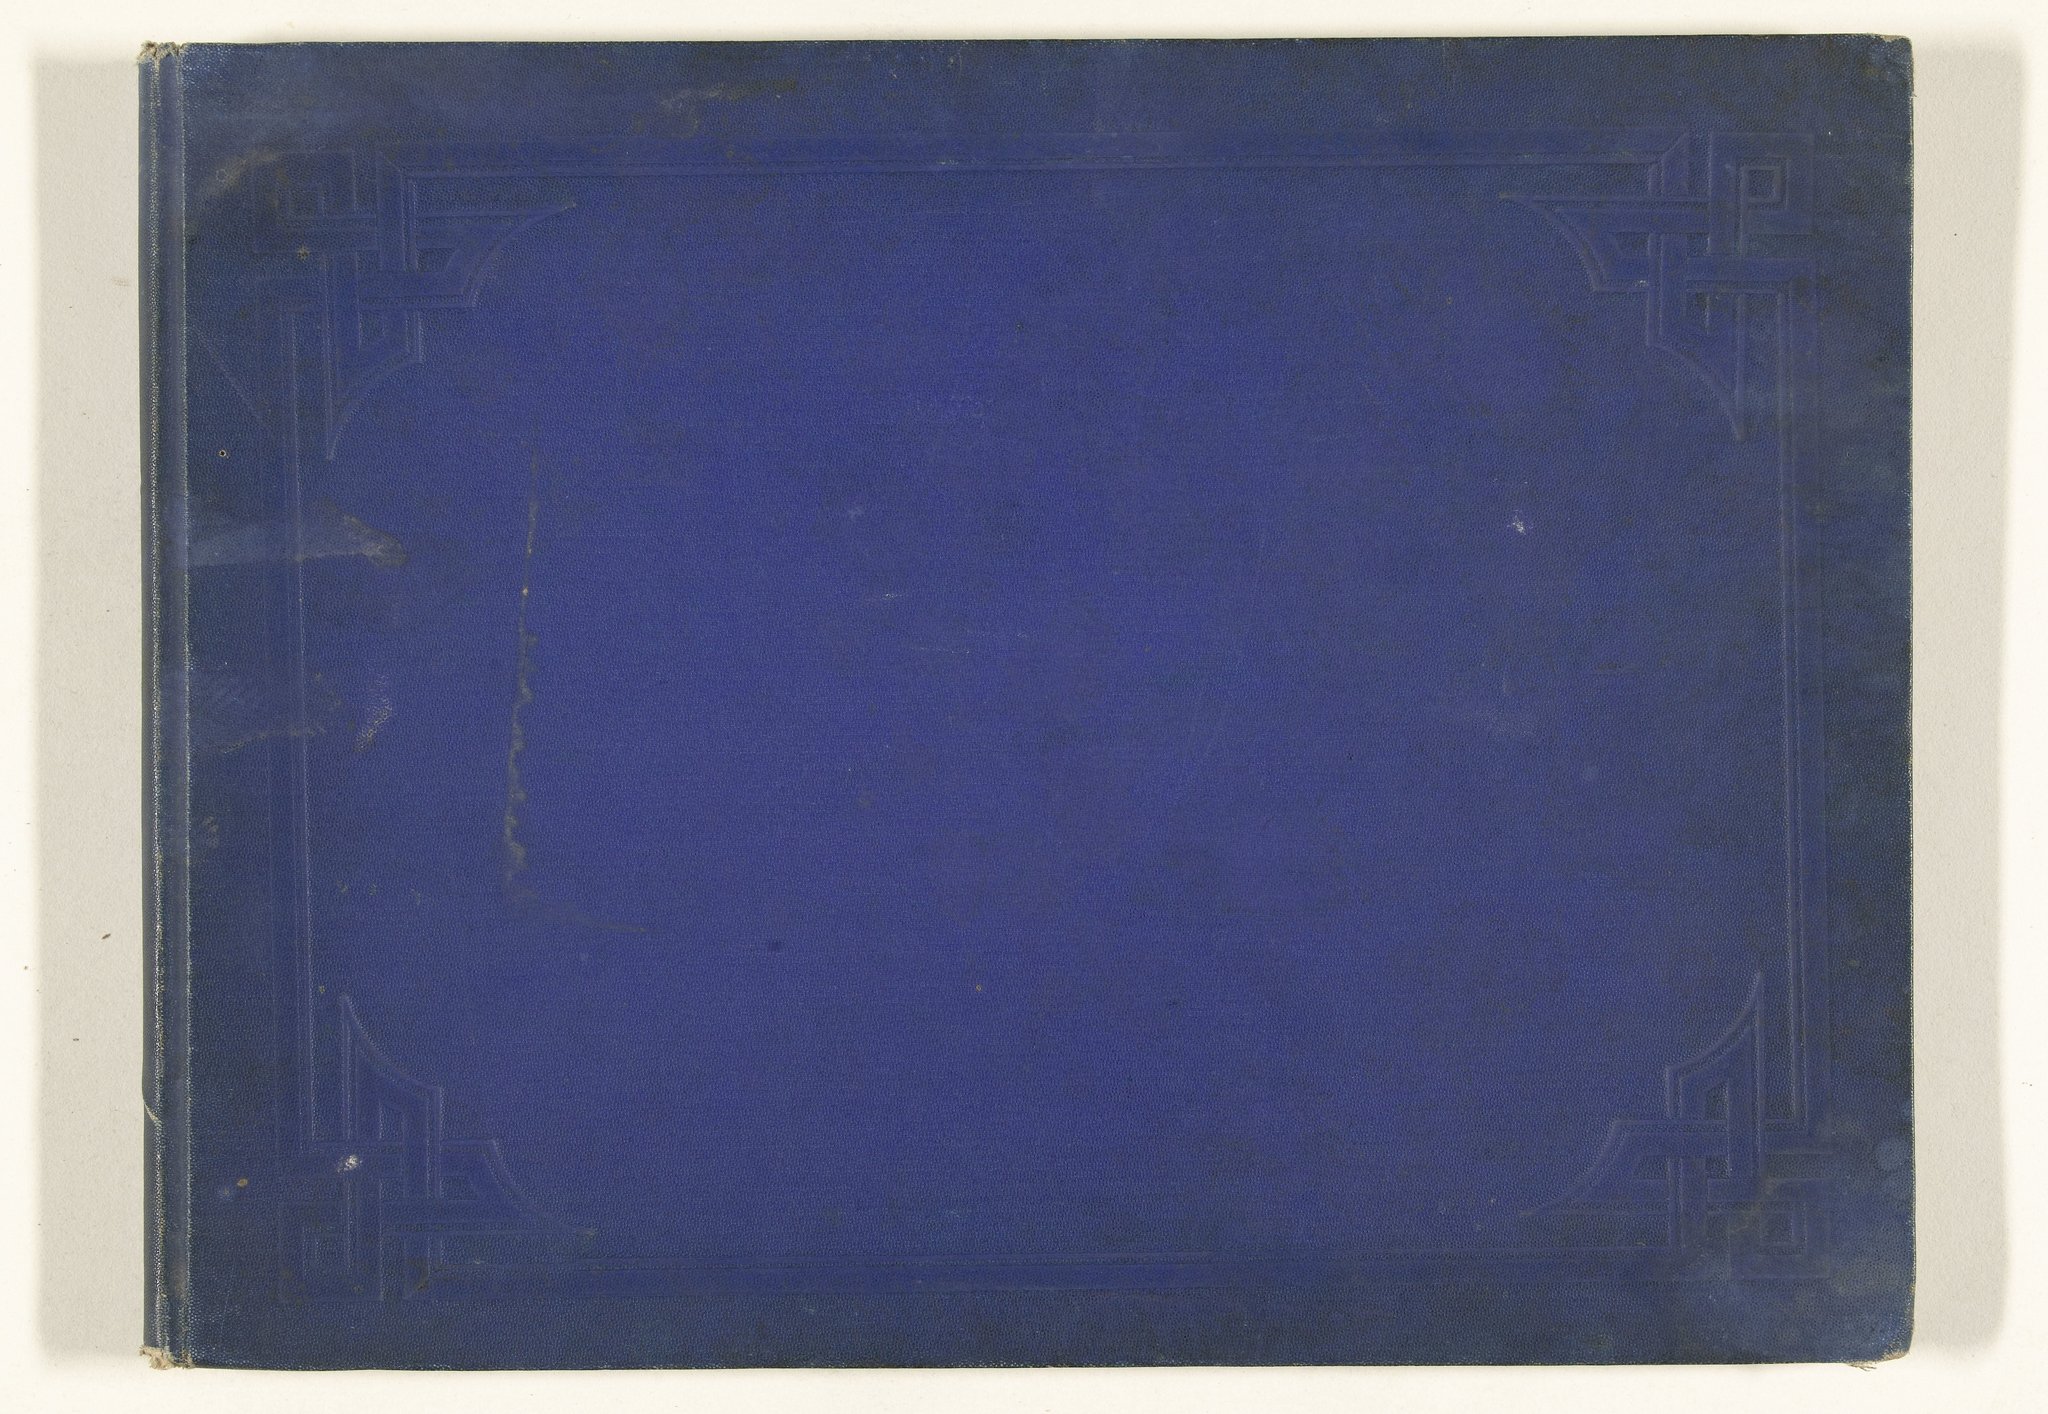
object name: scrapbook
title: Fotoalbum met foto's van Leiden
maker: Anonymous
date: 1900-1910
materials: paper, cardboard, linen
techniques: collodion silver print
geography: leiden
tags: canals, waters (in city), street, leiden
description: Fotoalbum met zeven foto's van huizen, plaatsen en een tram in Leiden. De foto's hebben handgeschreven bijschriften en zijn geplakt op bladen met decoratieve krullen rondom.